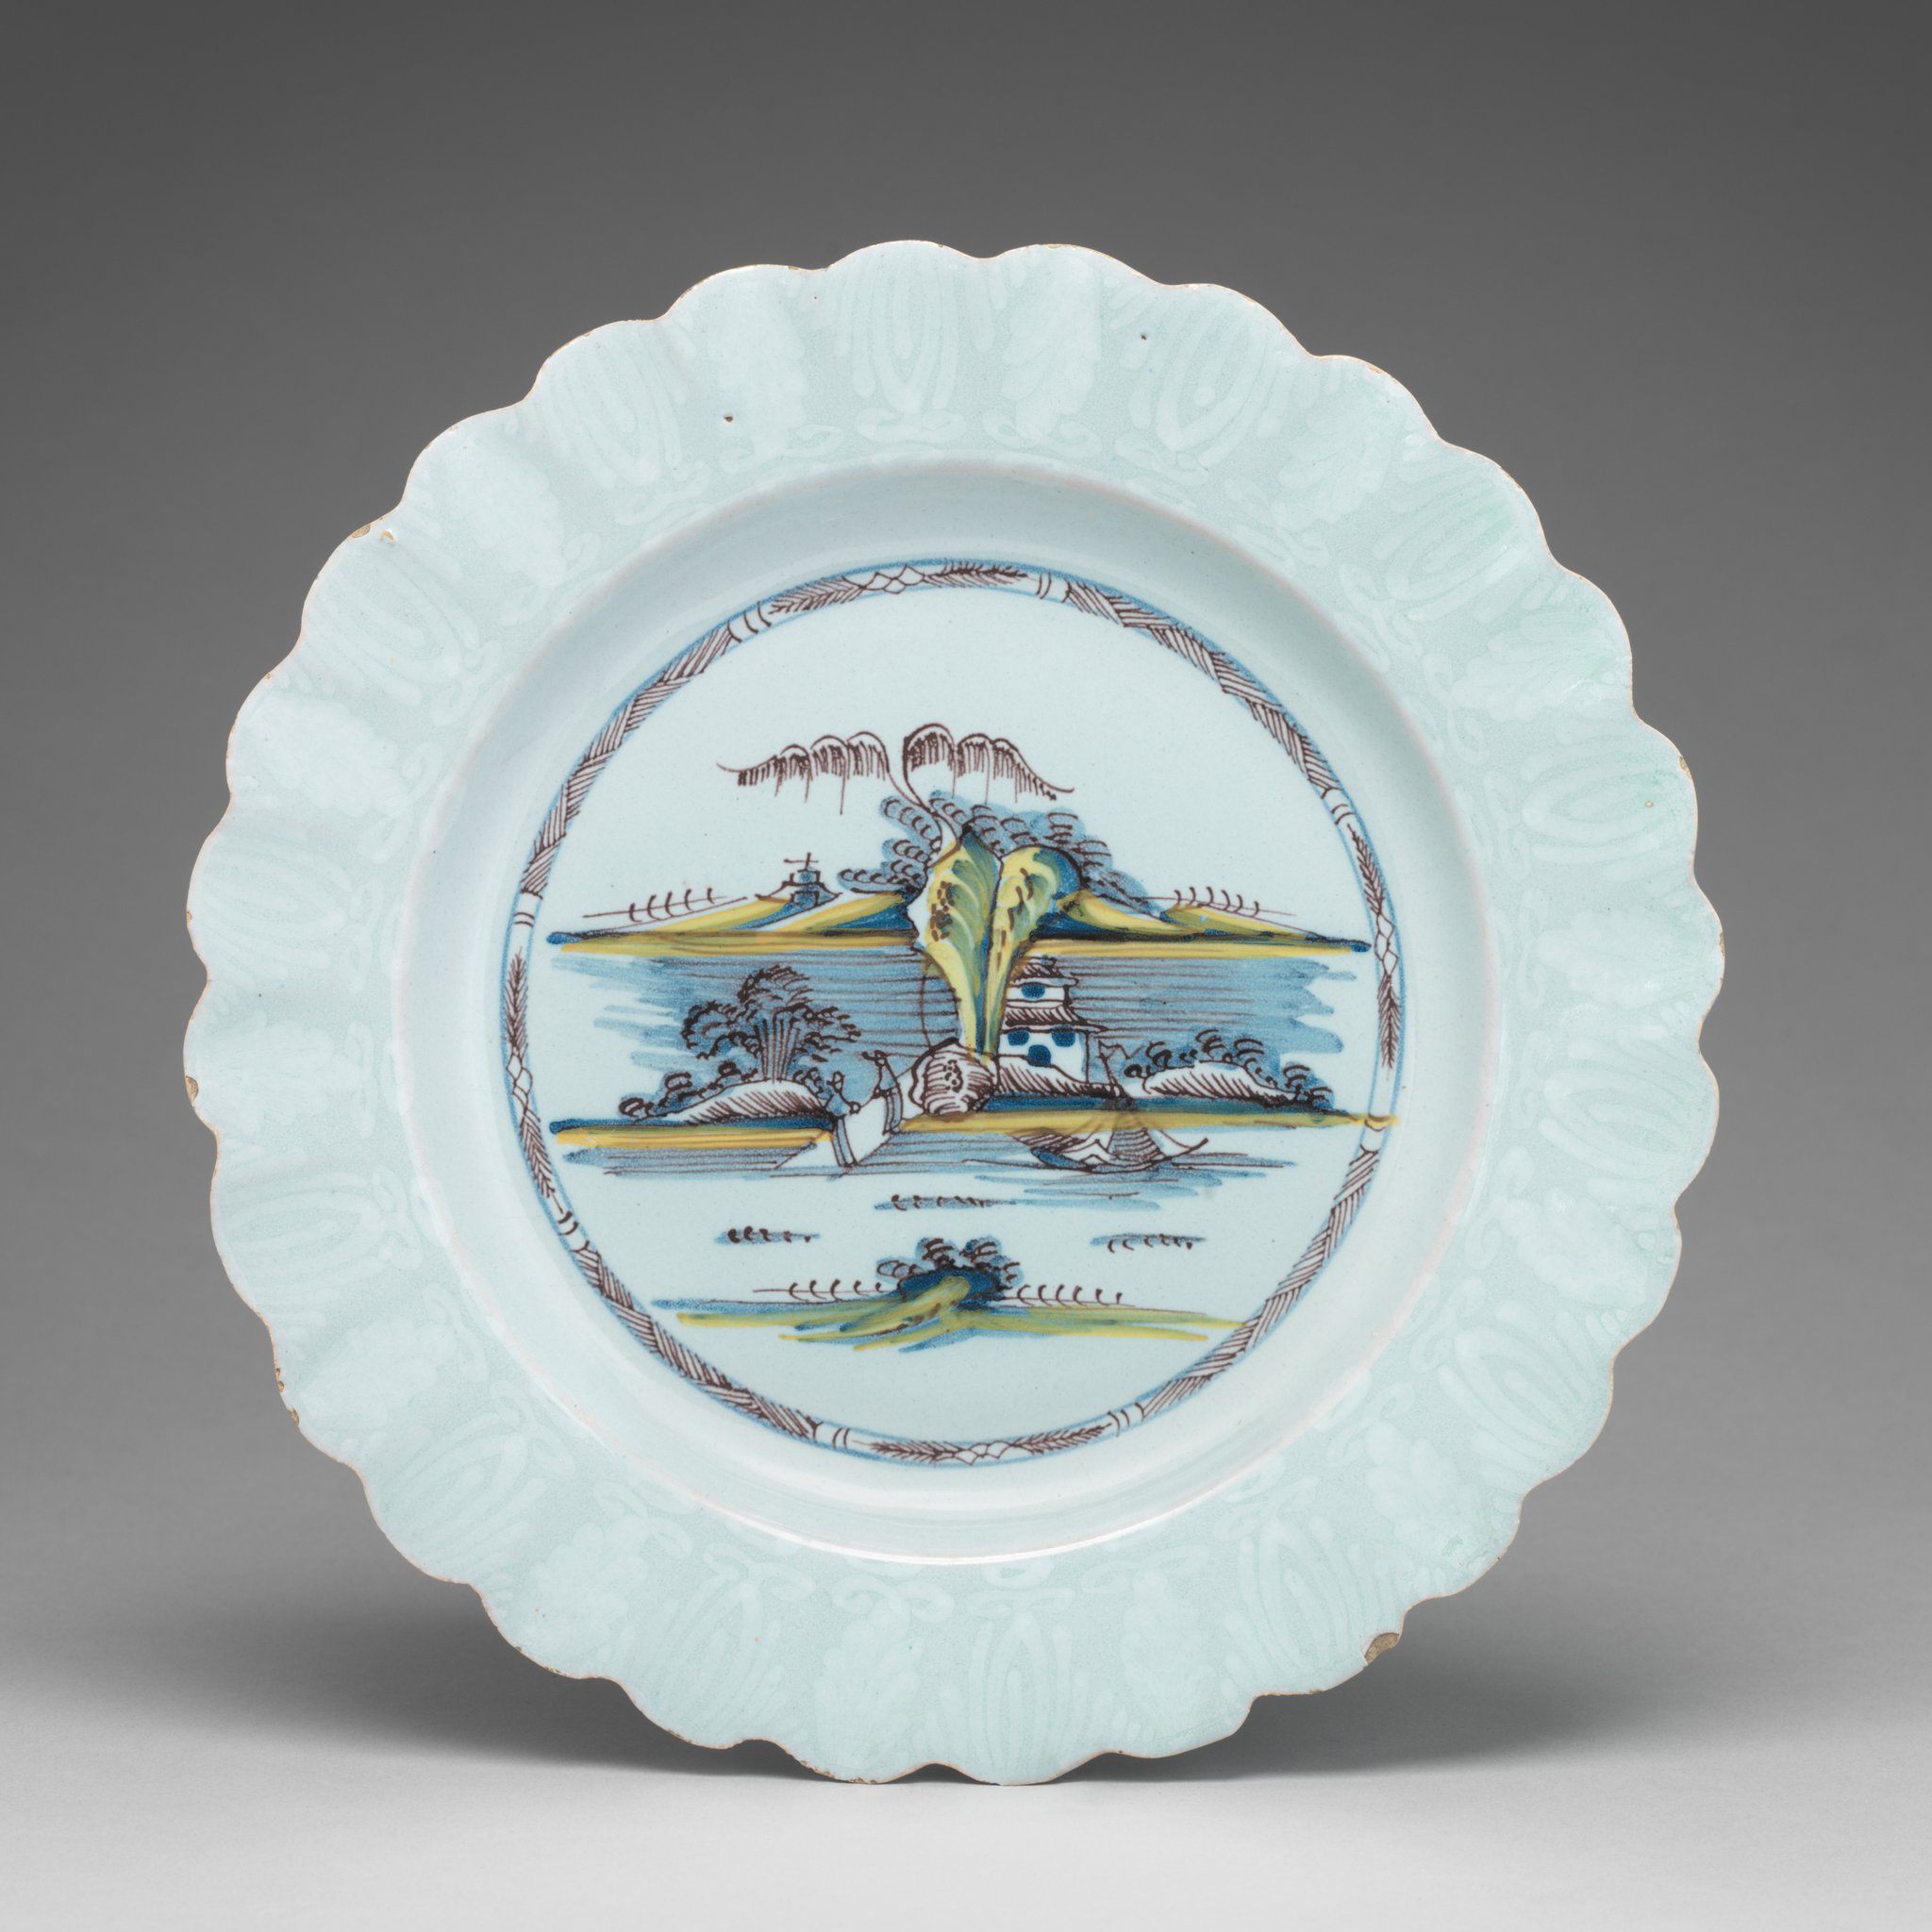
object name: plate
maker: joseph flower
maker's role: factory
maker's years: 1700-1800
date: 1760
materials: earthenware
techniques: glazing